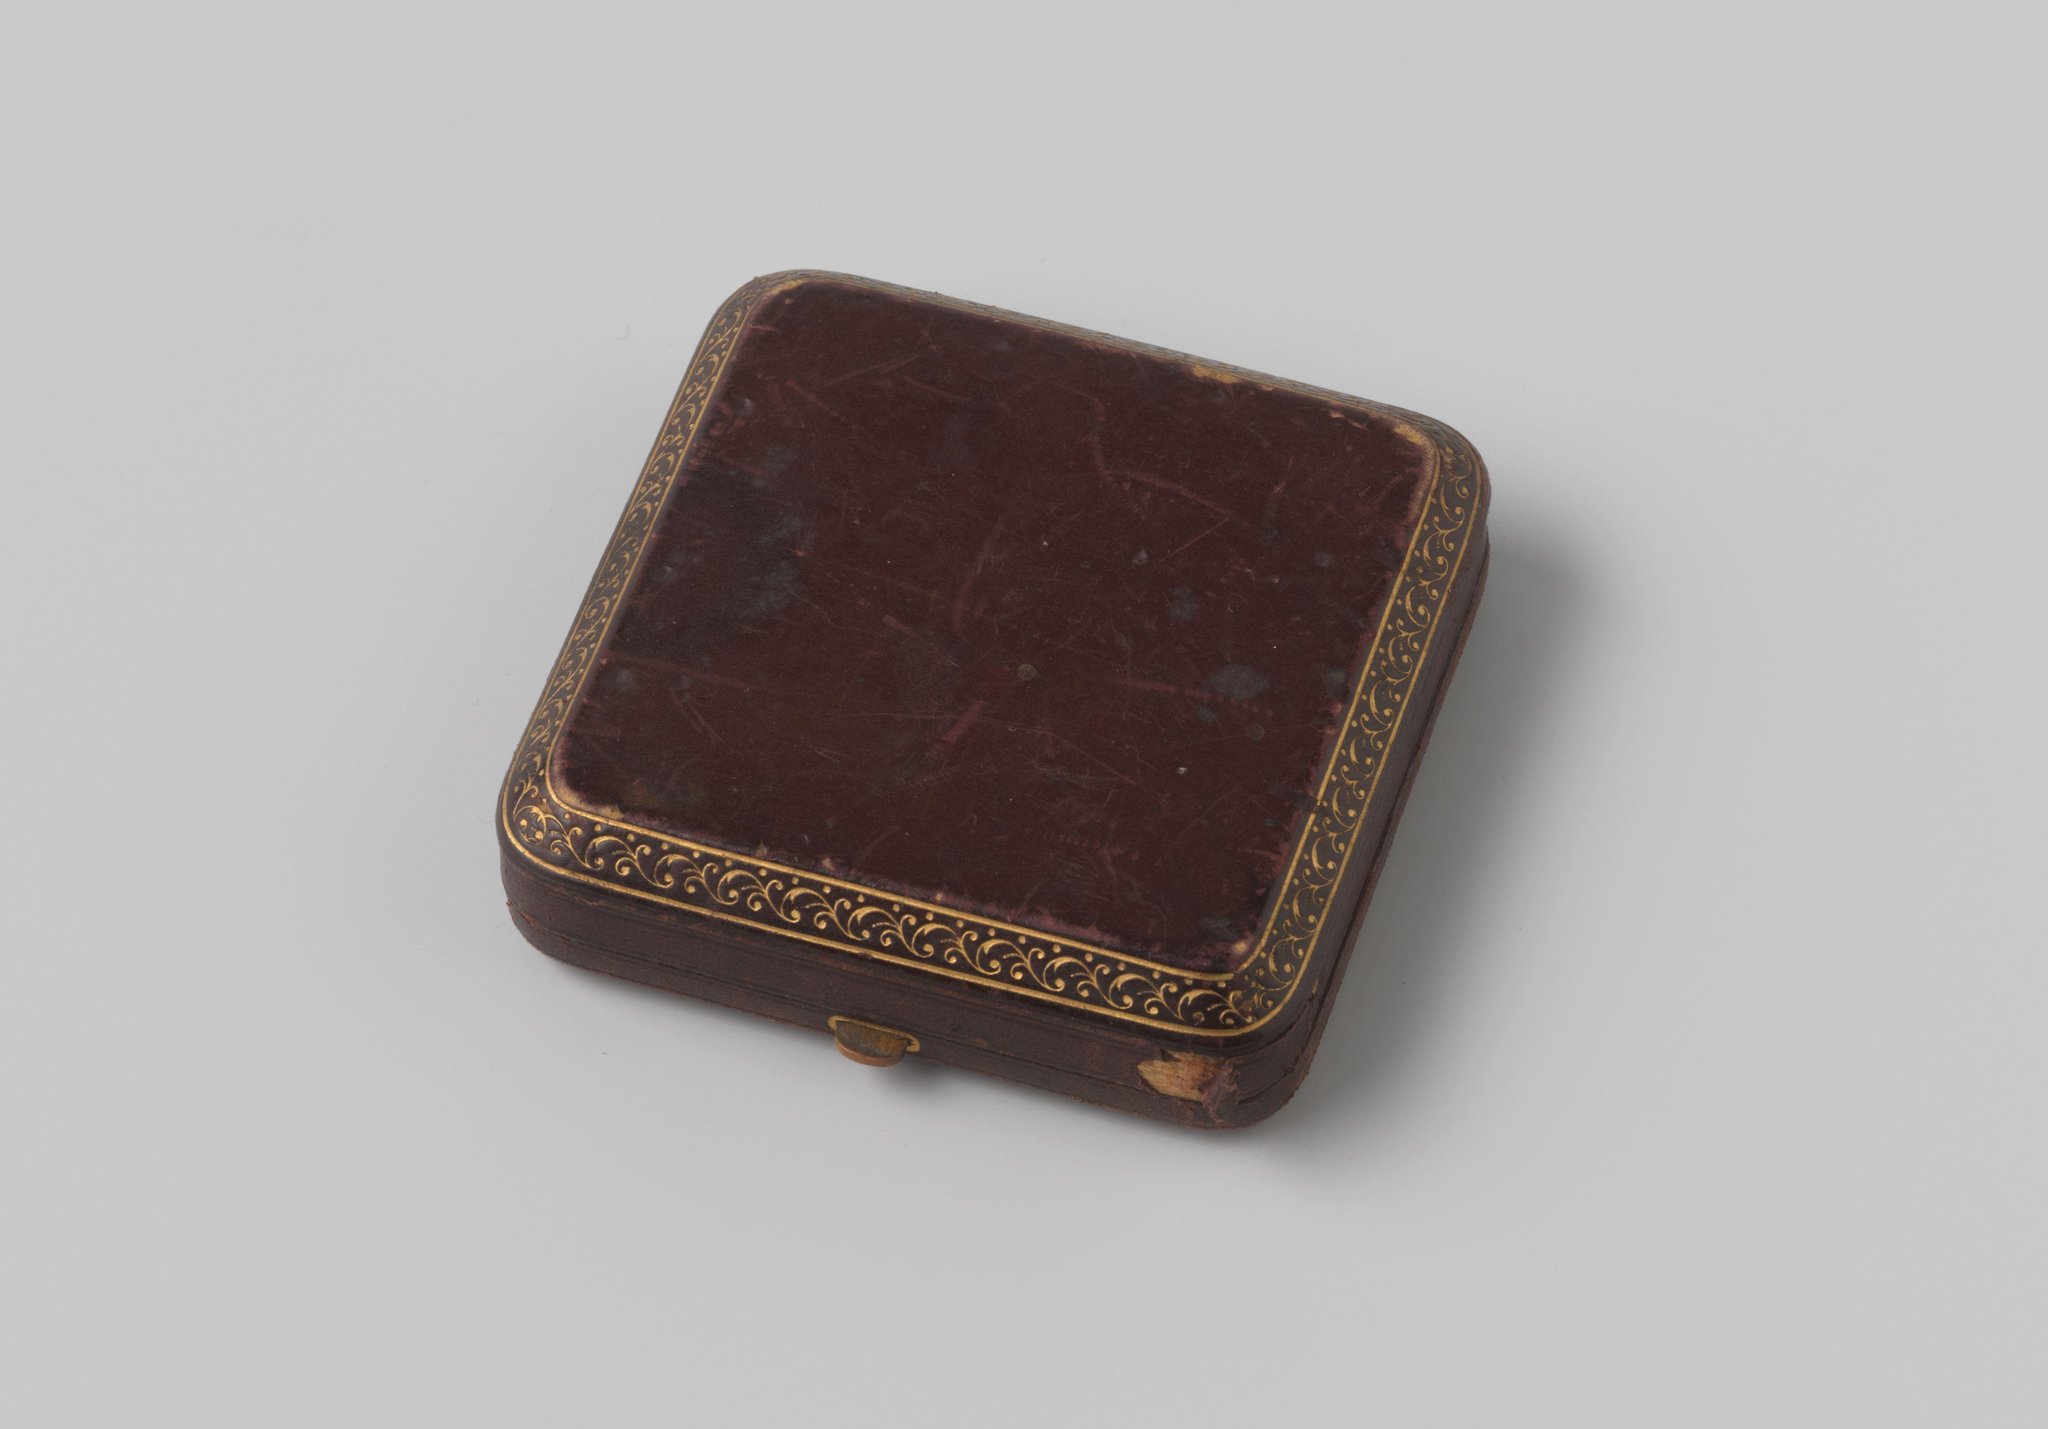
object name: box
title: Penningdoos van leer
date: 1891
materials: cardboard, leather, velvet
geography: utrecht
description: Vierkante bruinleren doos met knipsluiting, rondom bovenzijde goudbedrukte versiering; binnenzijde bekleed met groen fluweel, op beklede binnenzijde deksel naam van de leverancier (C.J. Begeer). Horend bij prijspenning NG-2014-22-1.